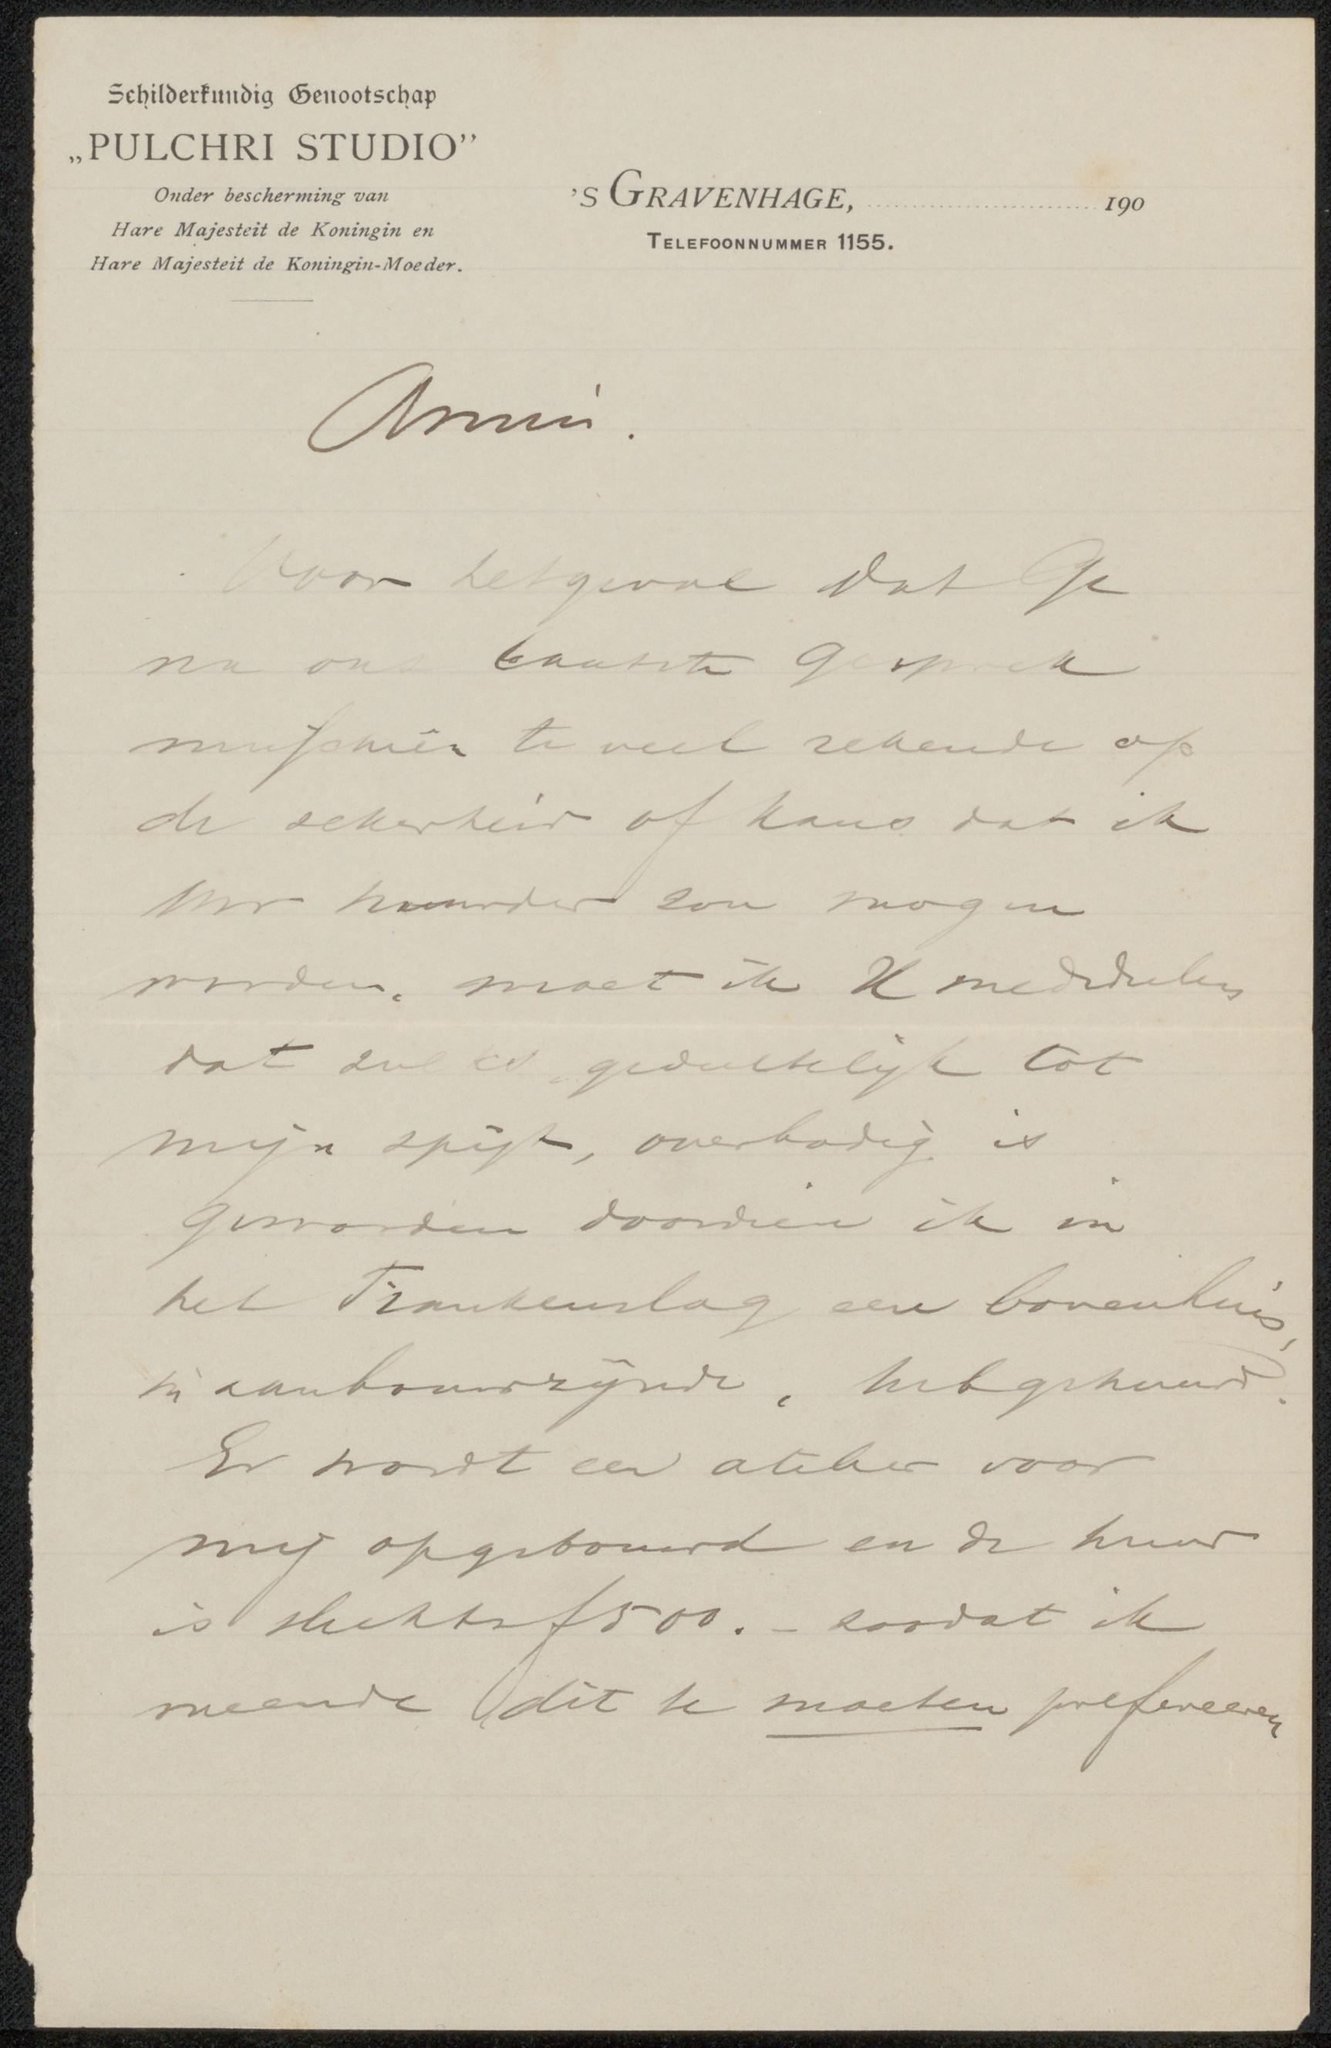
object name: letter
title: Brief aan Philip Zilcken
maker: tony lodewijk george offermans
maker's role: genreschilder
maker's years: 1854-1911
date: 1900-1911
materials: ink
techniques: pen, printing, writing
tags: the hague, painter, draughtsman, philip zilcken, workshop, studio of the artist (in general), money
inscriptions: collector's mark: ‘RPK’